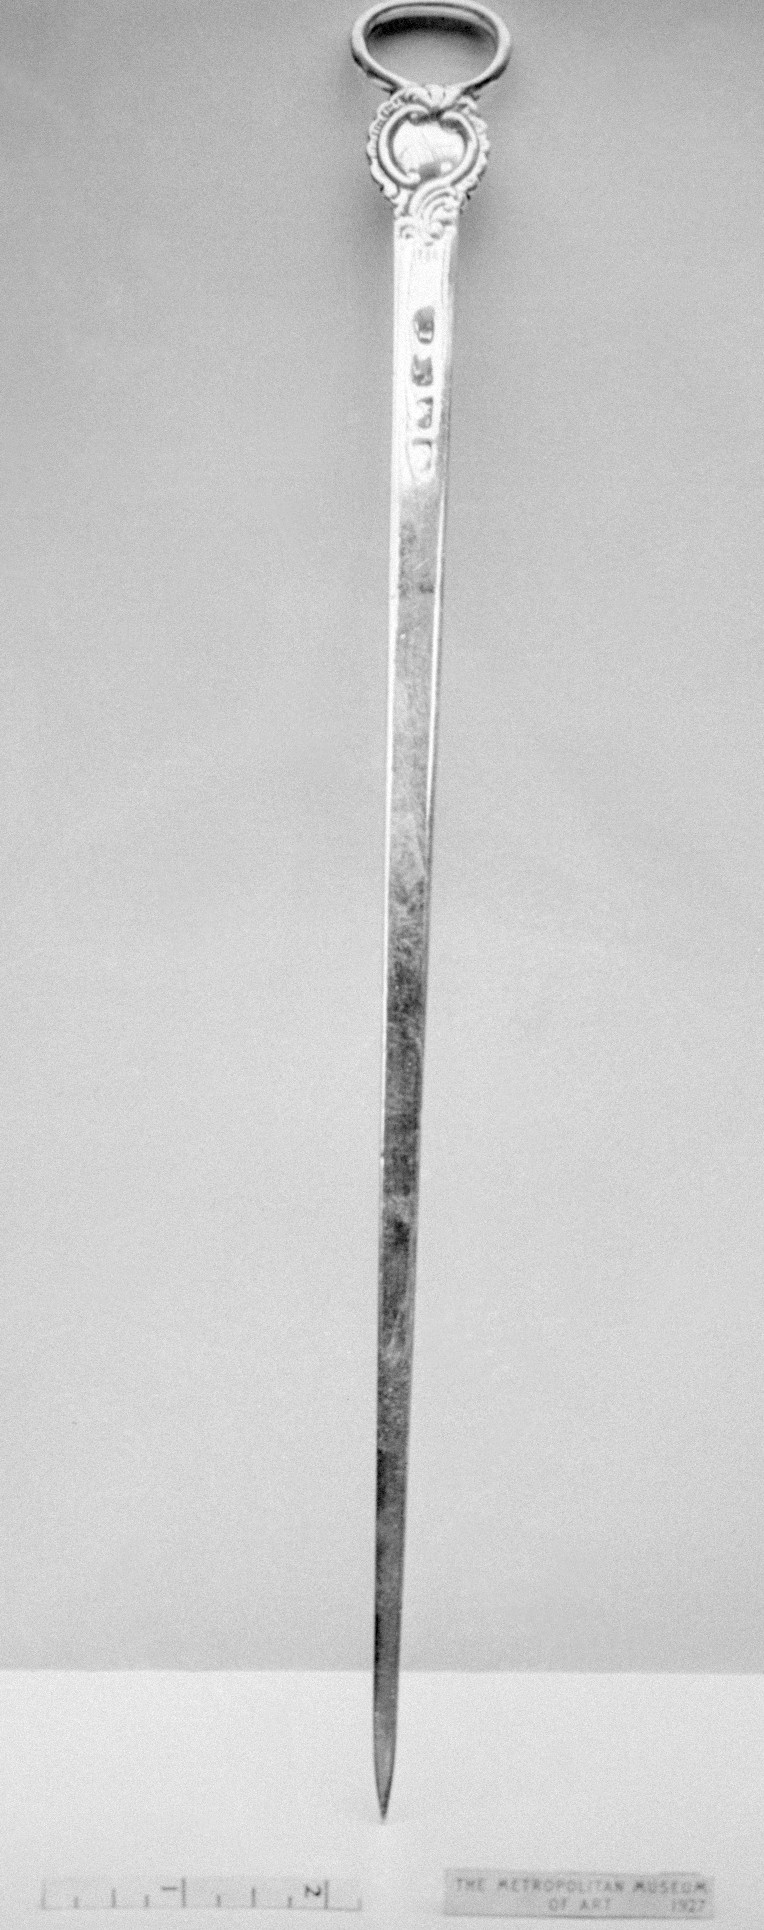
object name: skewer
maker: john sanders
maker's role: maker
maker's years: 1717-1748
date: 1740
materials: silver